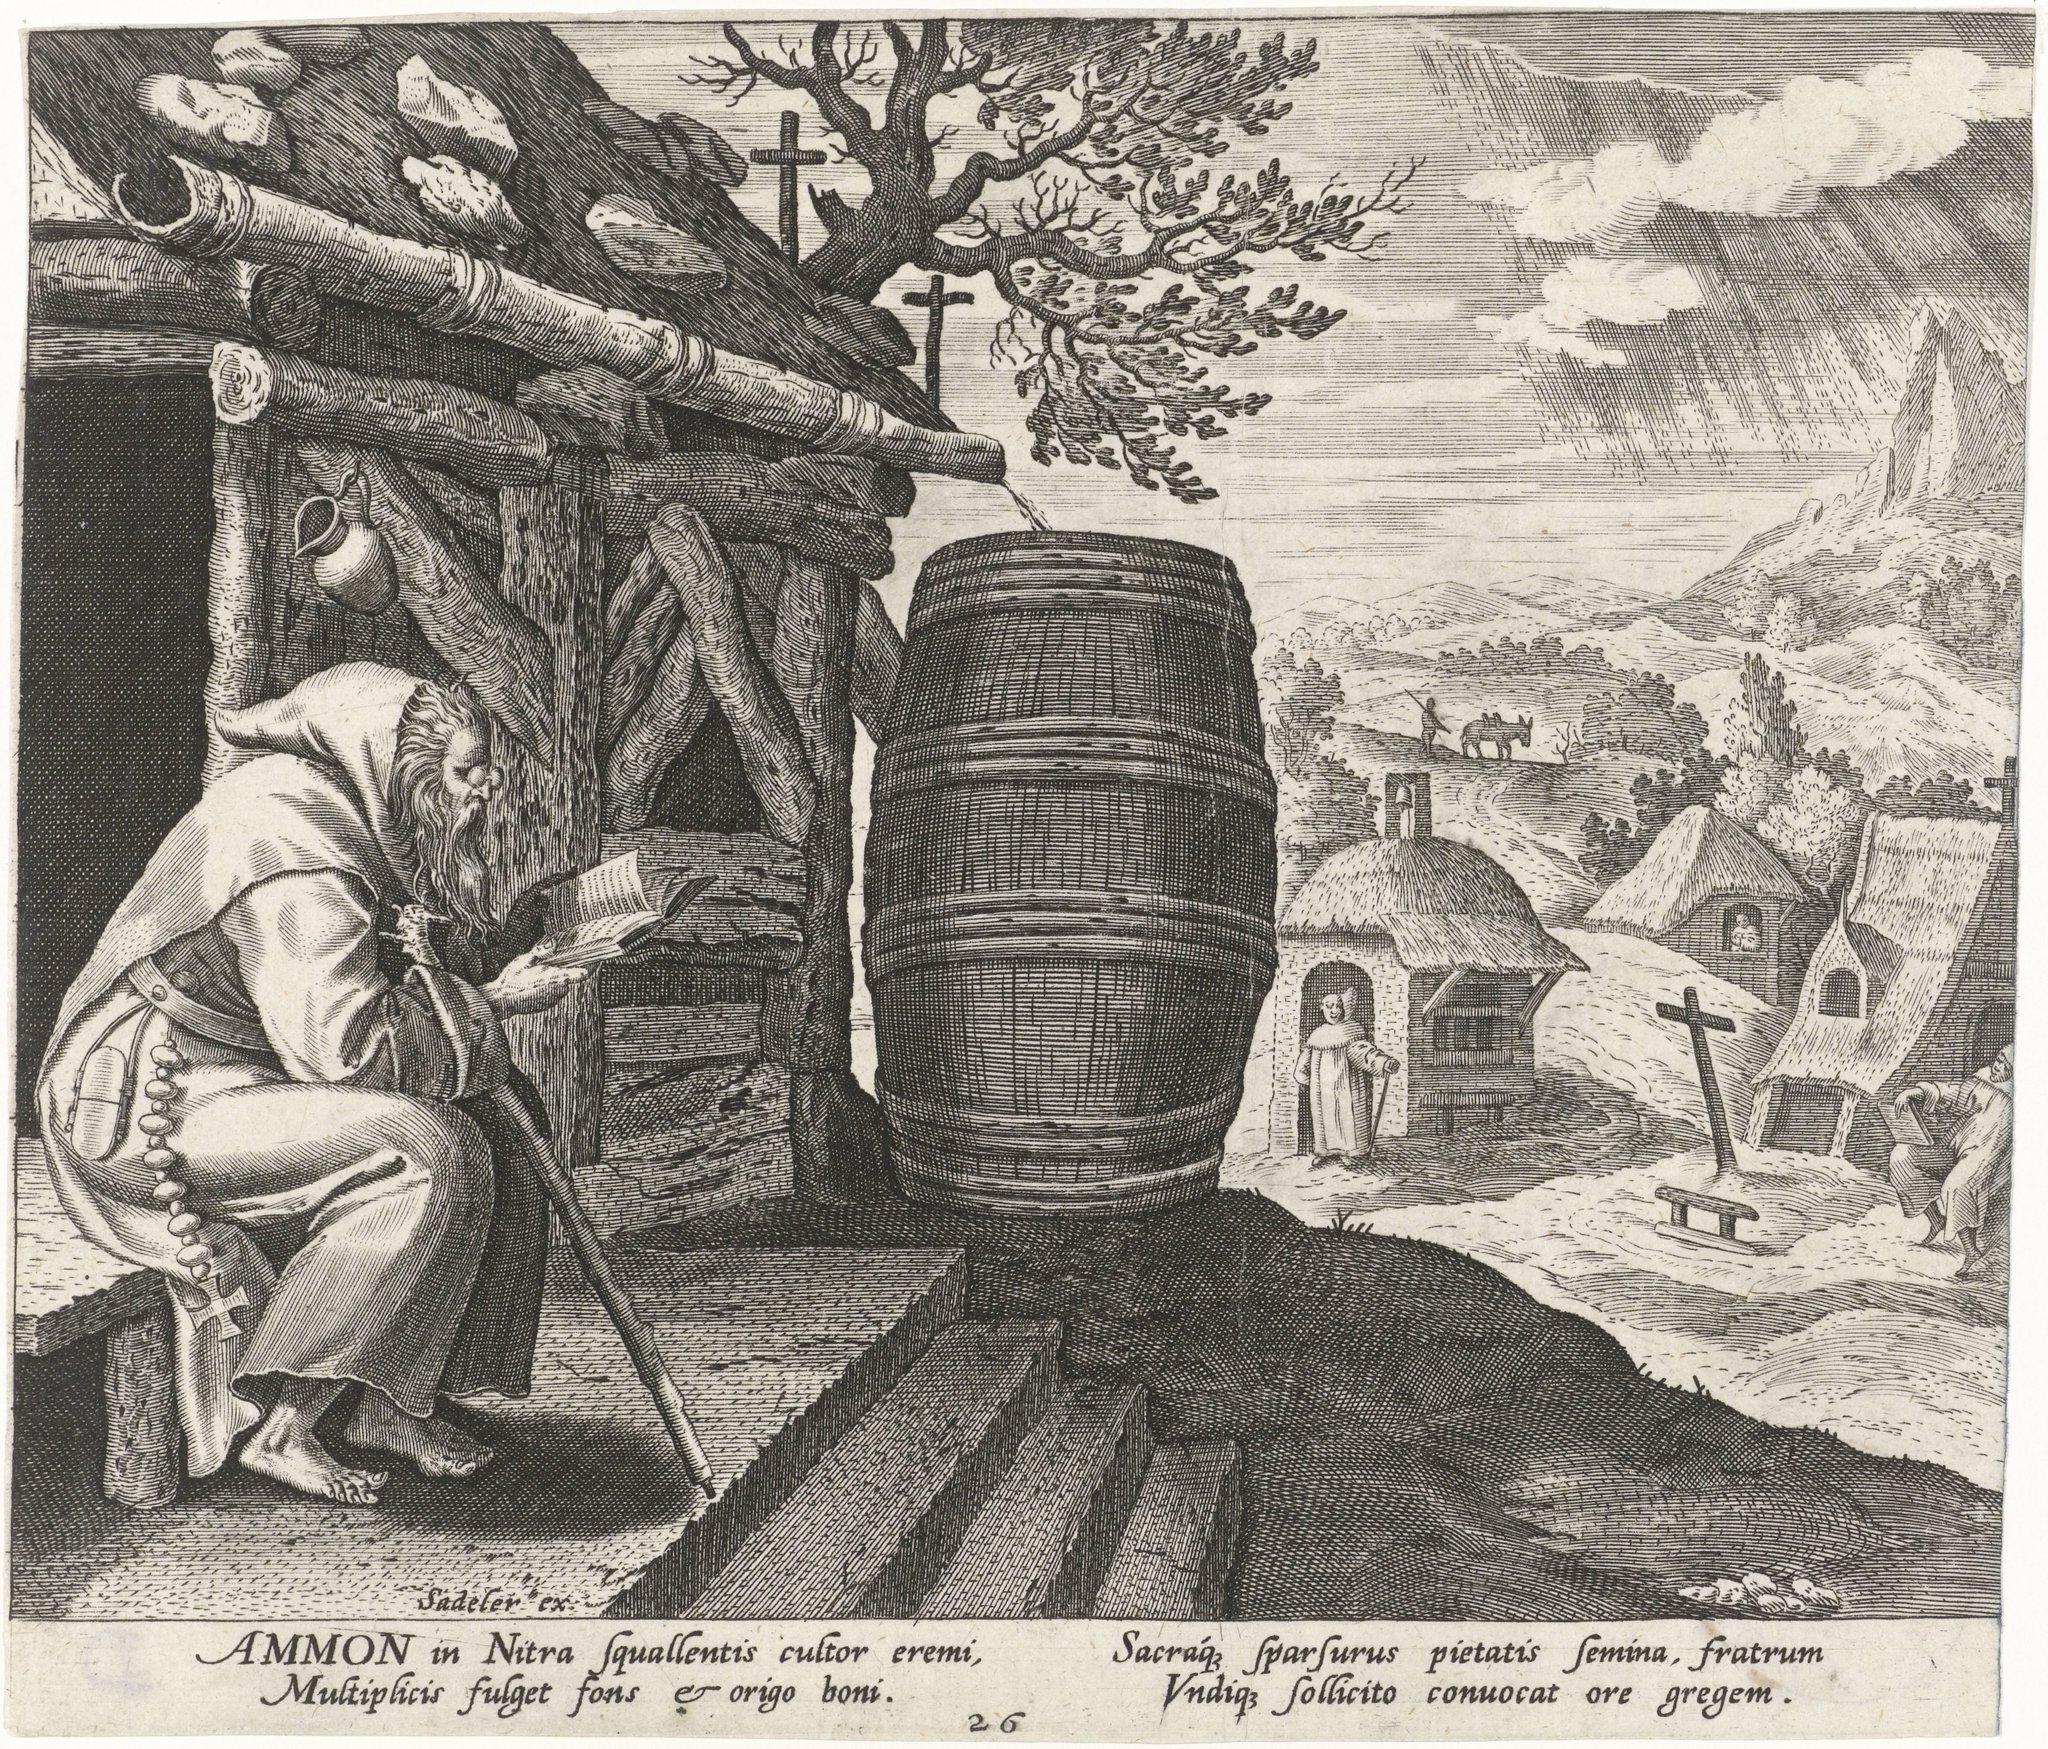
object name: print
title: Ammonius de Grote als kluizenaar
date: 1586-1588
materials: paper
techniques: engraving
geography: antwerp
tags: male saints (with name), anchorite, hermit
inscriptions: collector's mark: Lugt 240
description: De H. Ammonius de Grote in een monnikenpij. Hij zit op een bank voor zijn hut en leest uit een bijbel. Op de achtergrond een kluizenaarsdorp. Op de achtergrond andere kluizenaars.